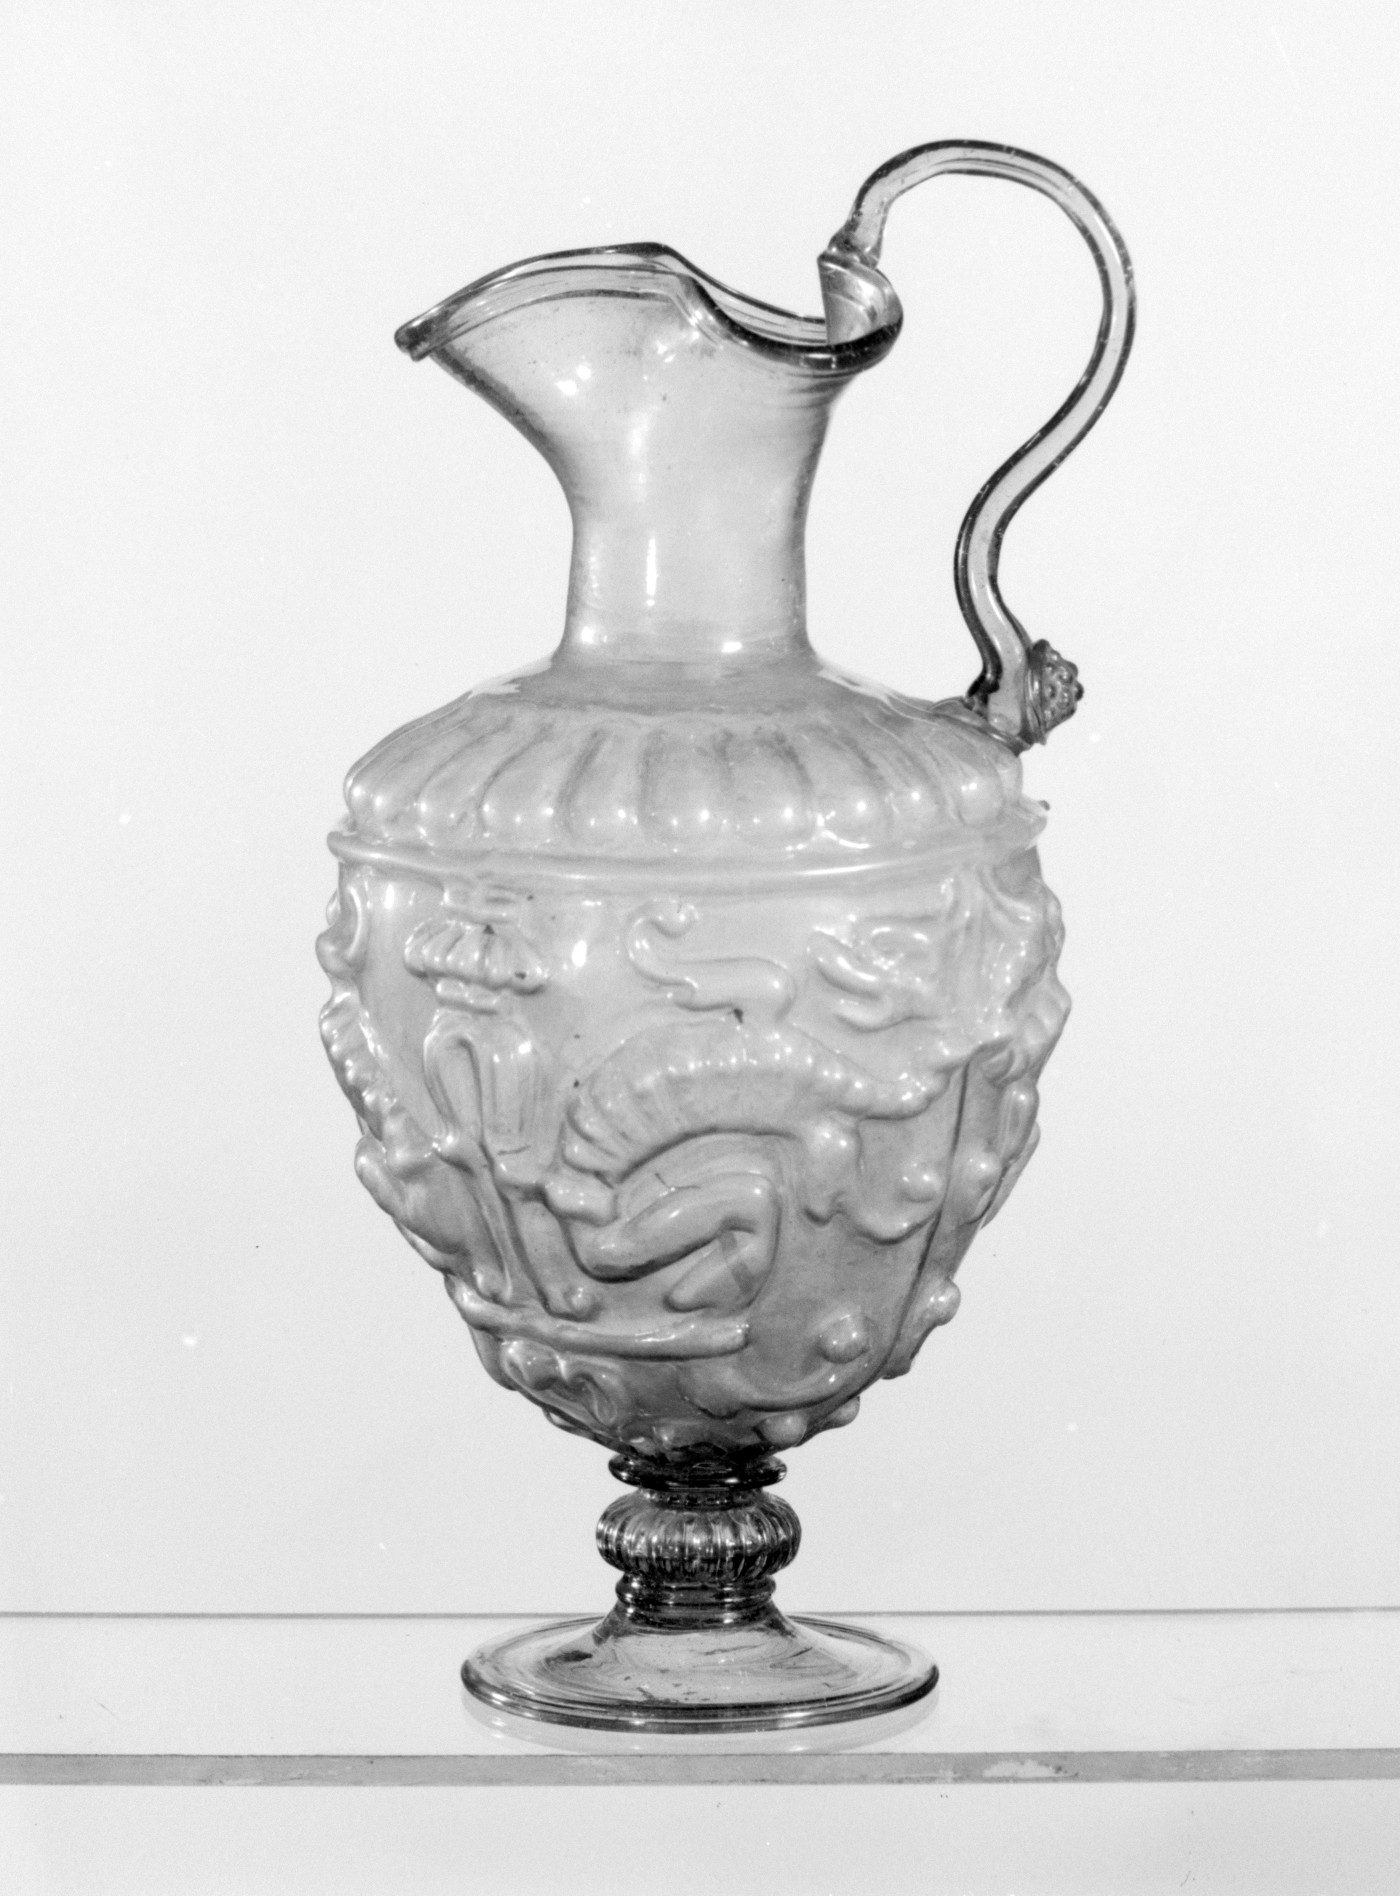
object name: ewer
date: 1501-1600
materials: glass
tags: dragons